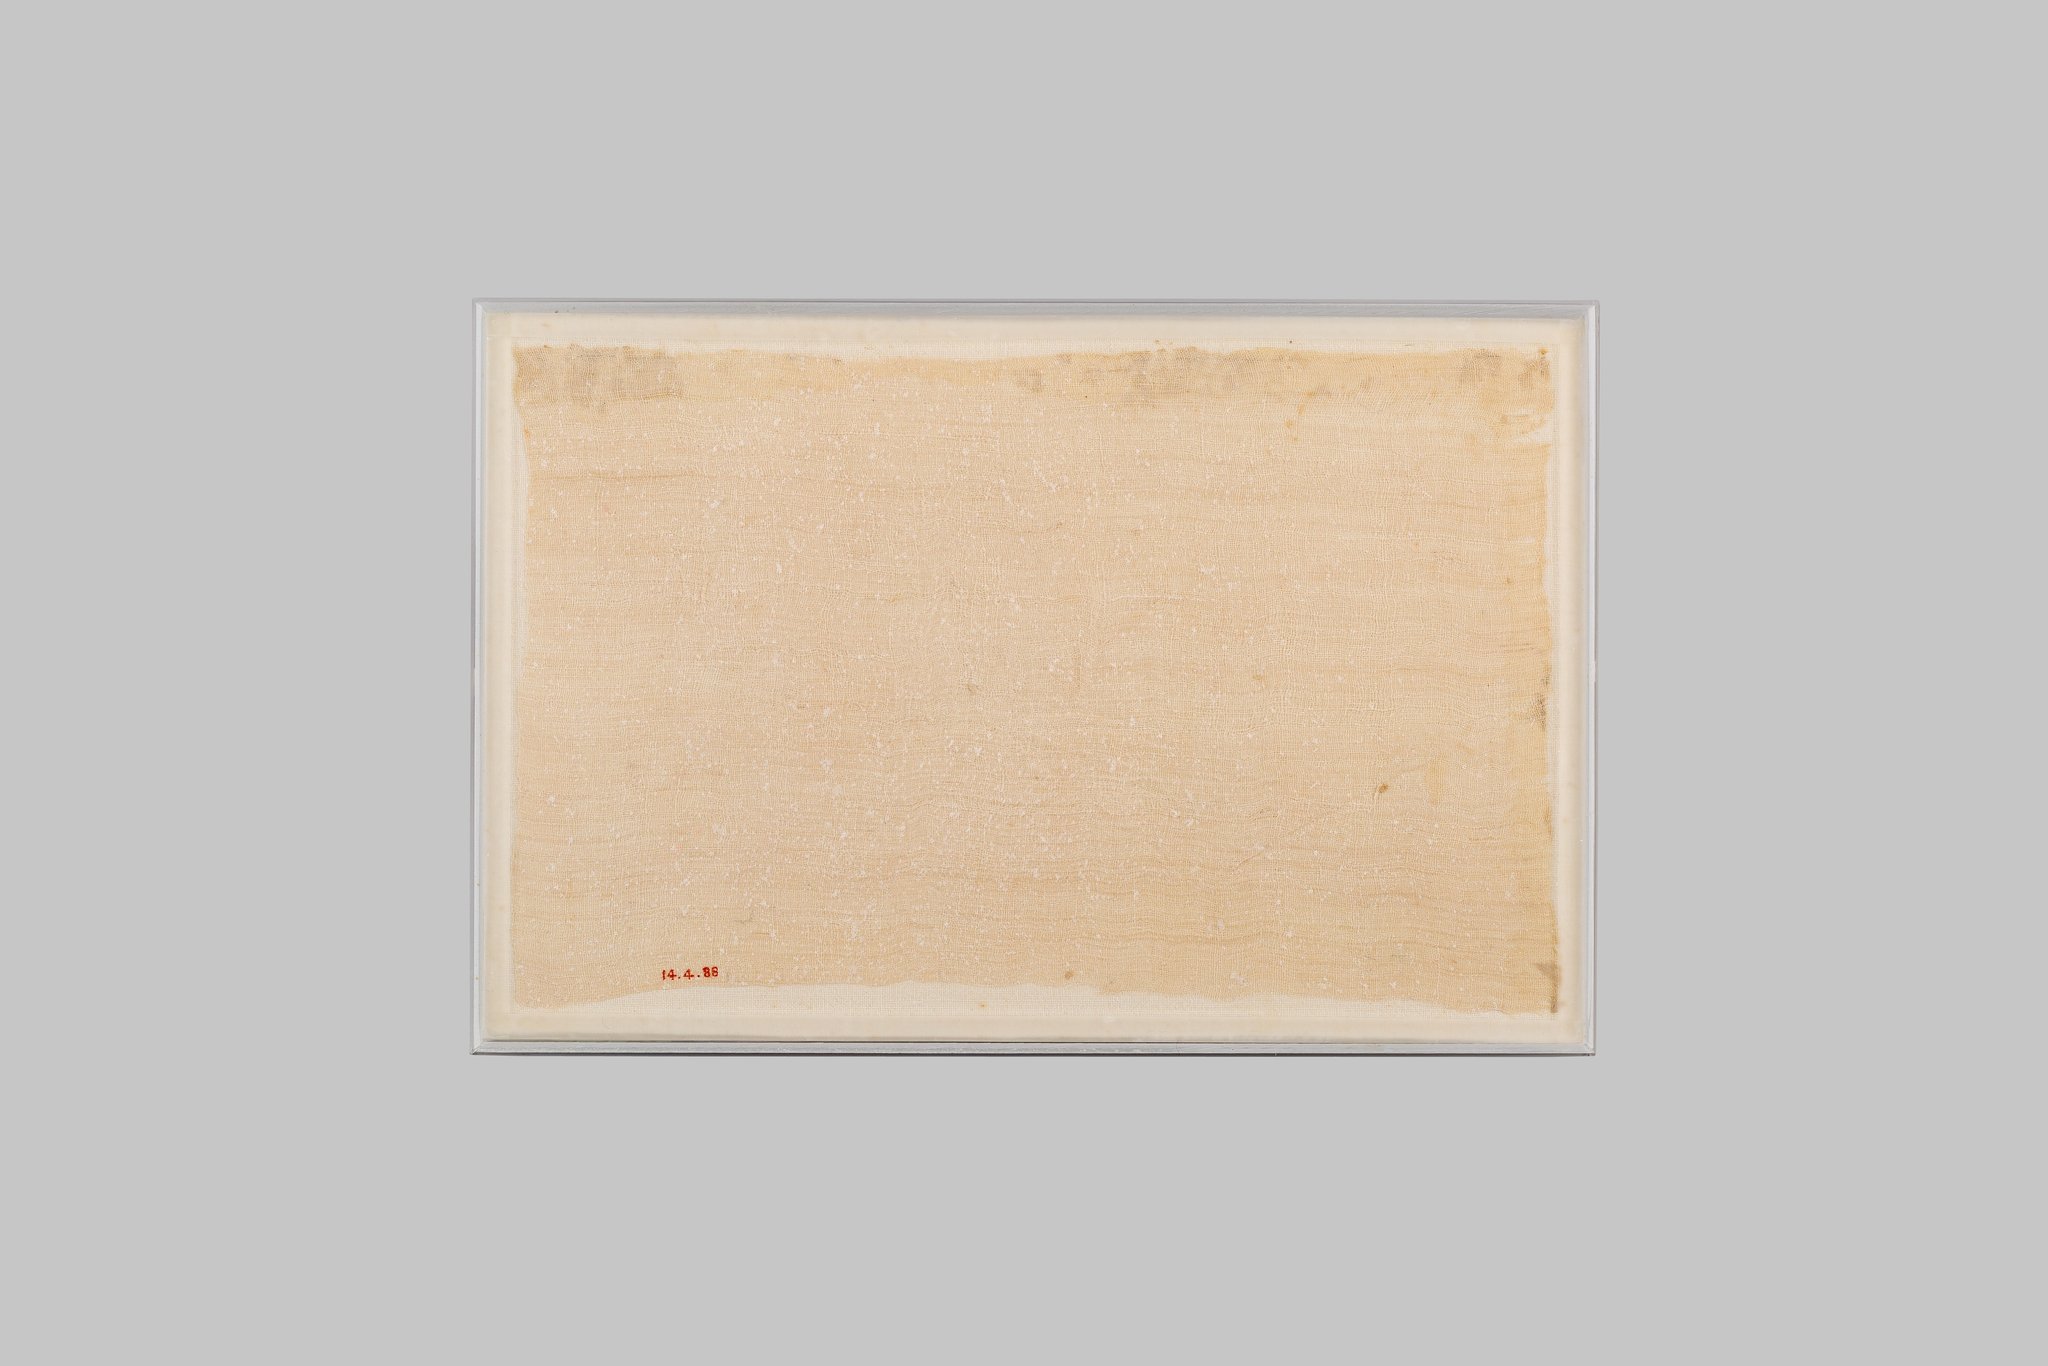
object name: linen fragment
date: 2880-2465 BCE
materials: linen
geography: egypt